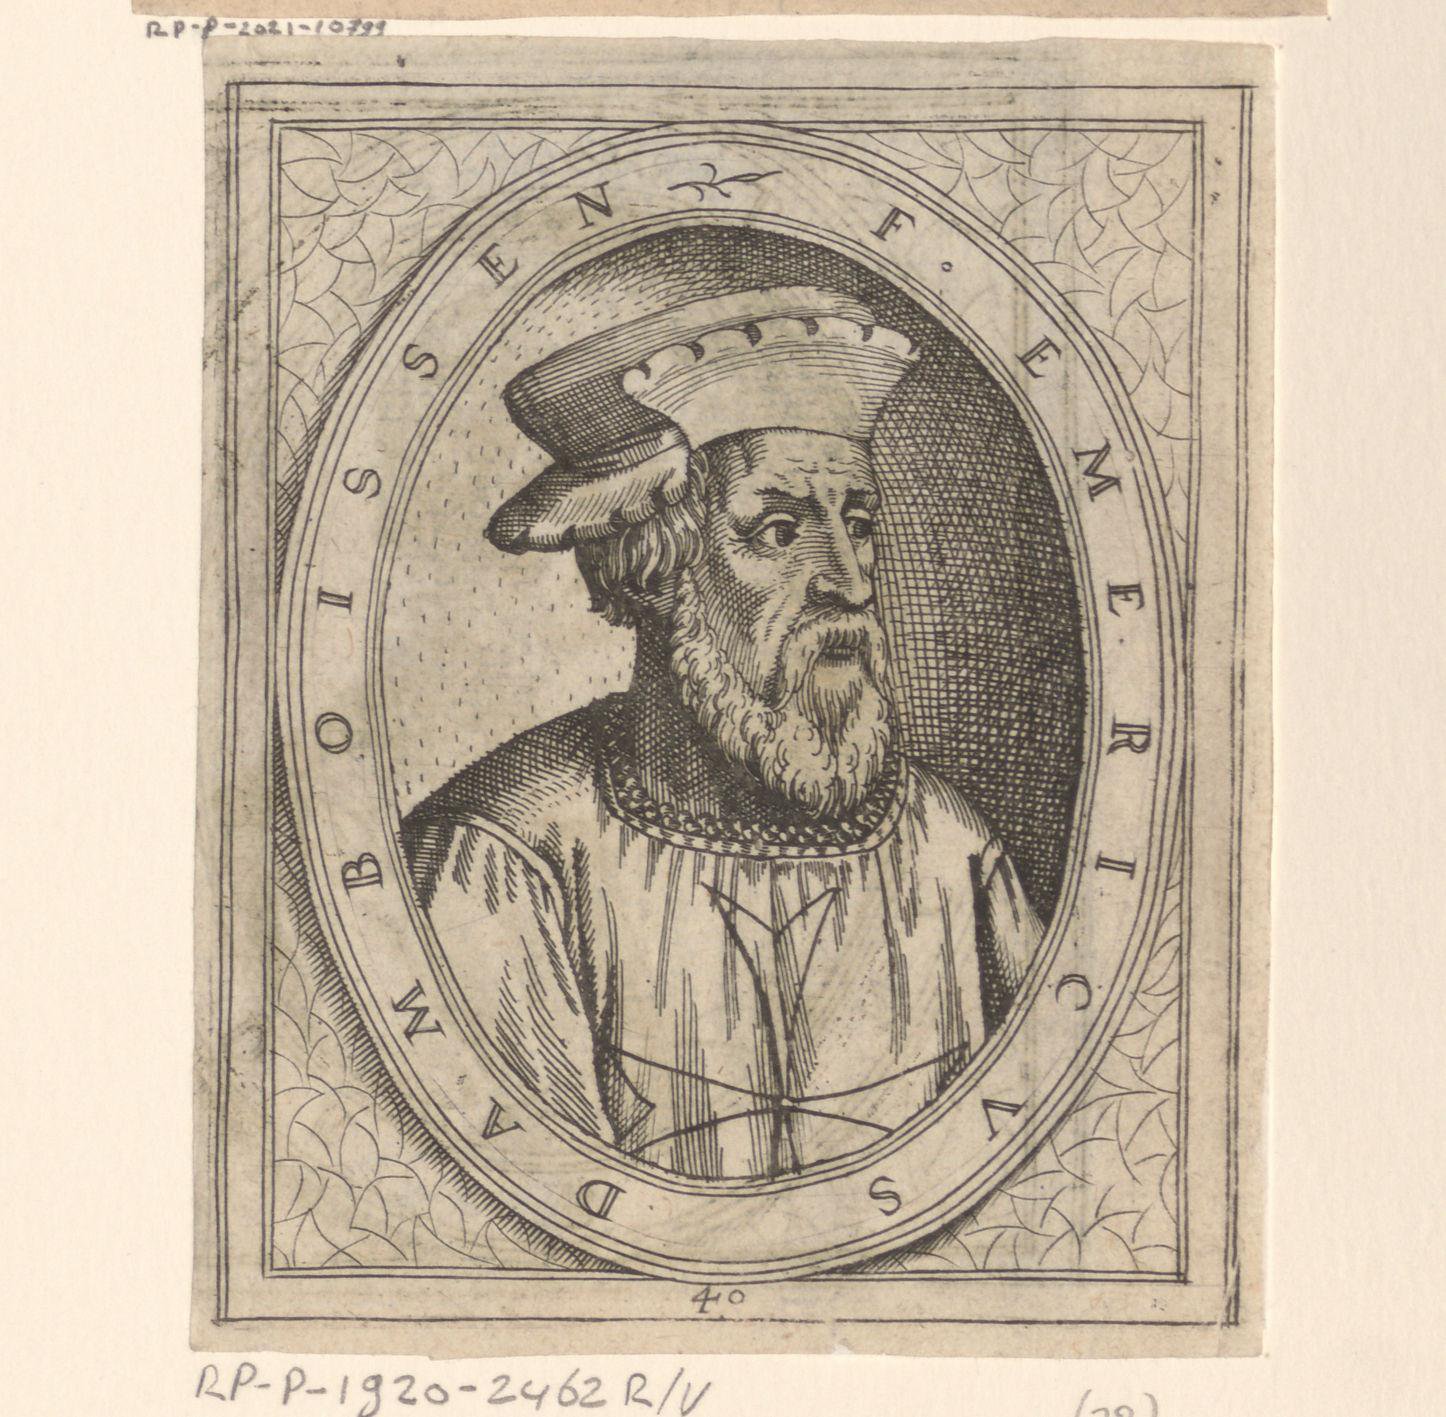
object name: print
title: Portret van Emery d'Amboise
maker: Anonymous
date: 1643-1659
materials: paper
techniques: engraving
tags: historical persons, military orders, e.g.: knights templars, knights of malta, teutonic knights ~ roman catholic church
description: Prent mogelijk uit: Baudoin, Jean. Histoire des chevaliers de l'ordre de s. Jean de Hierusalem (...). Parijs: Jacques Dallin, 1643. Of uit: Baudoin, Jean. Histoire des chevaliers de l'ordre de s. Jean de Hierusalem (...). Parijs: Thomas Jolly, 1659.